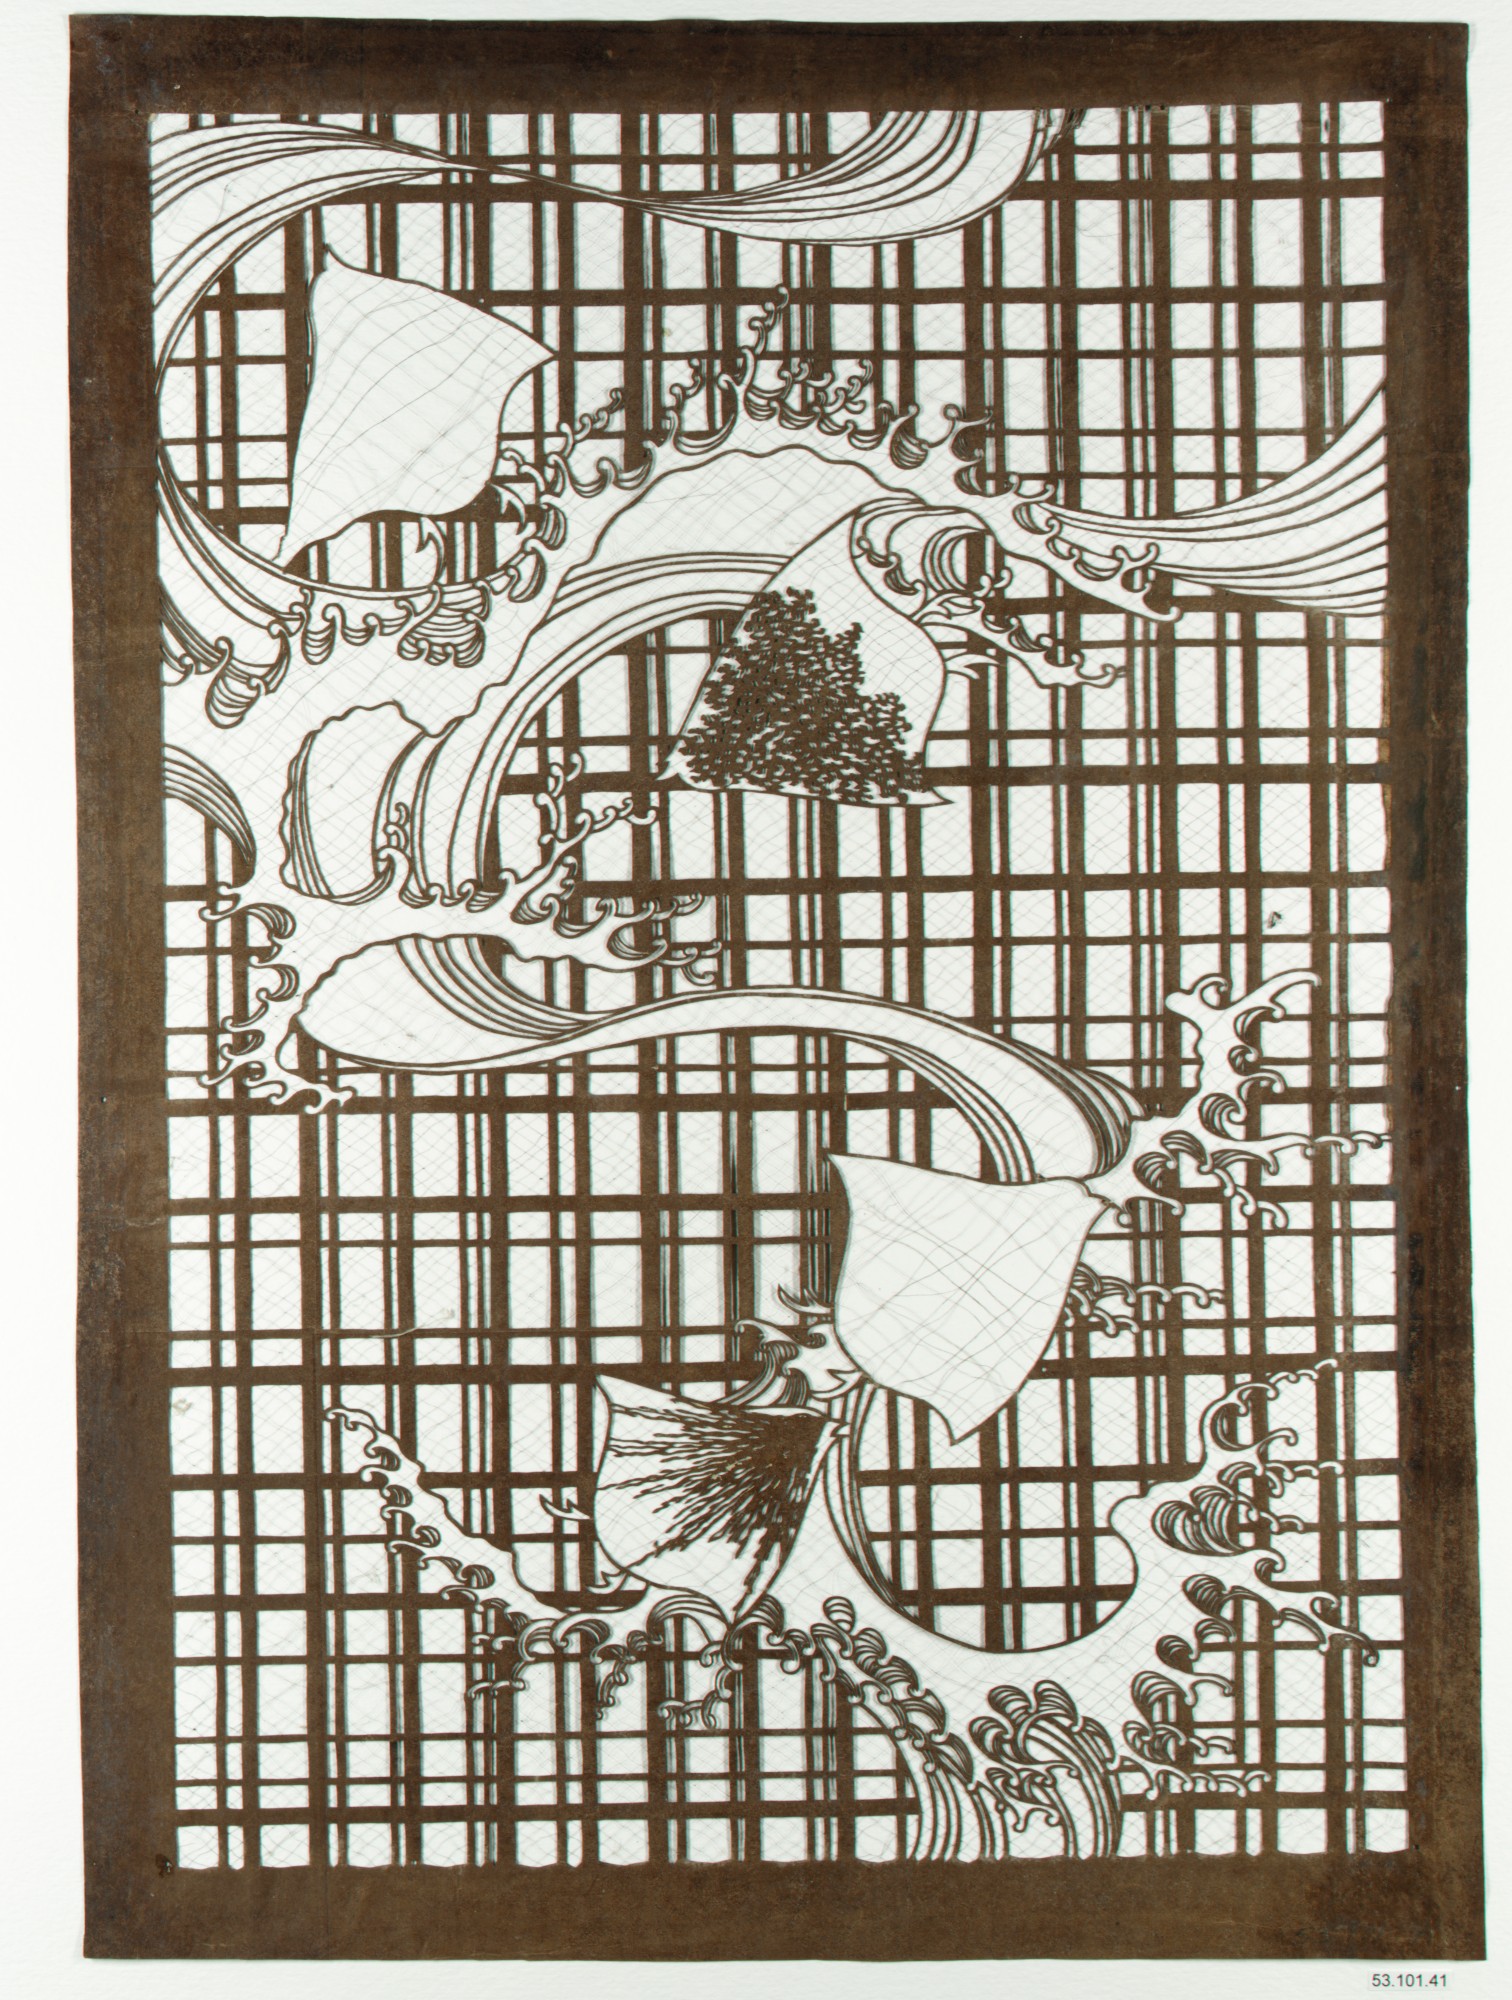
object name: stencil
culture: japanese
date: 1615-1868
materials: paper